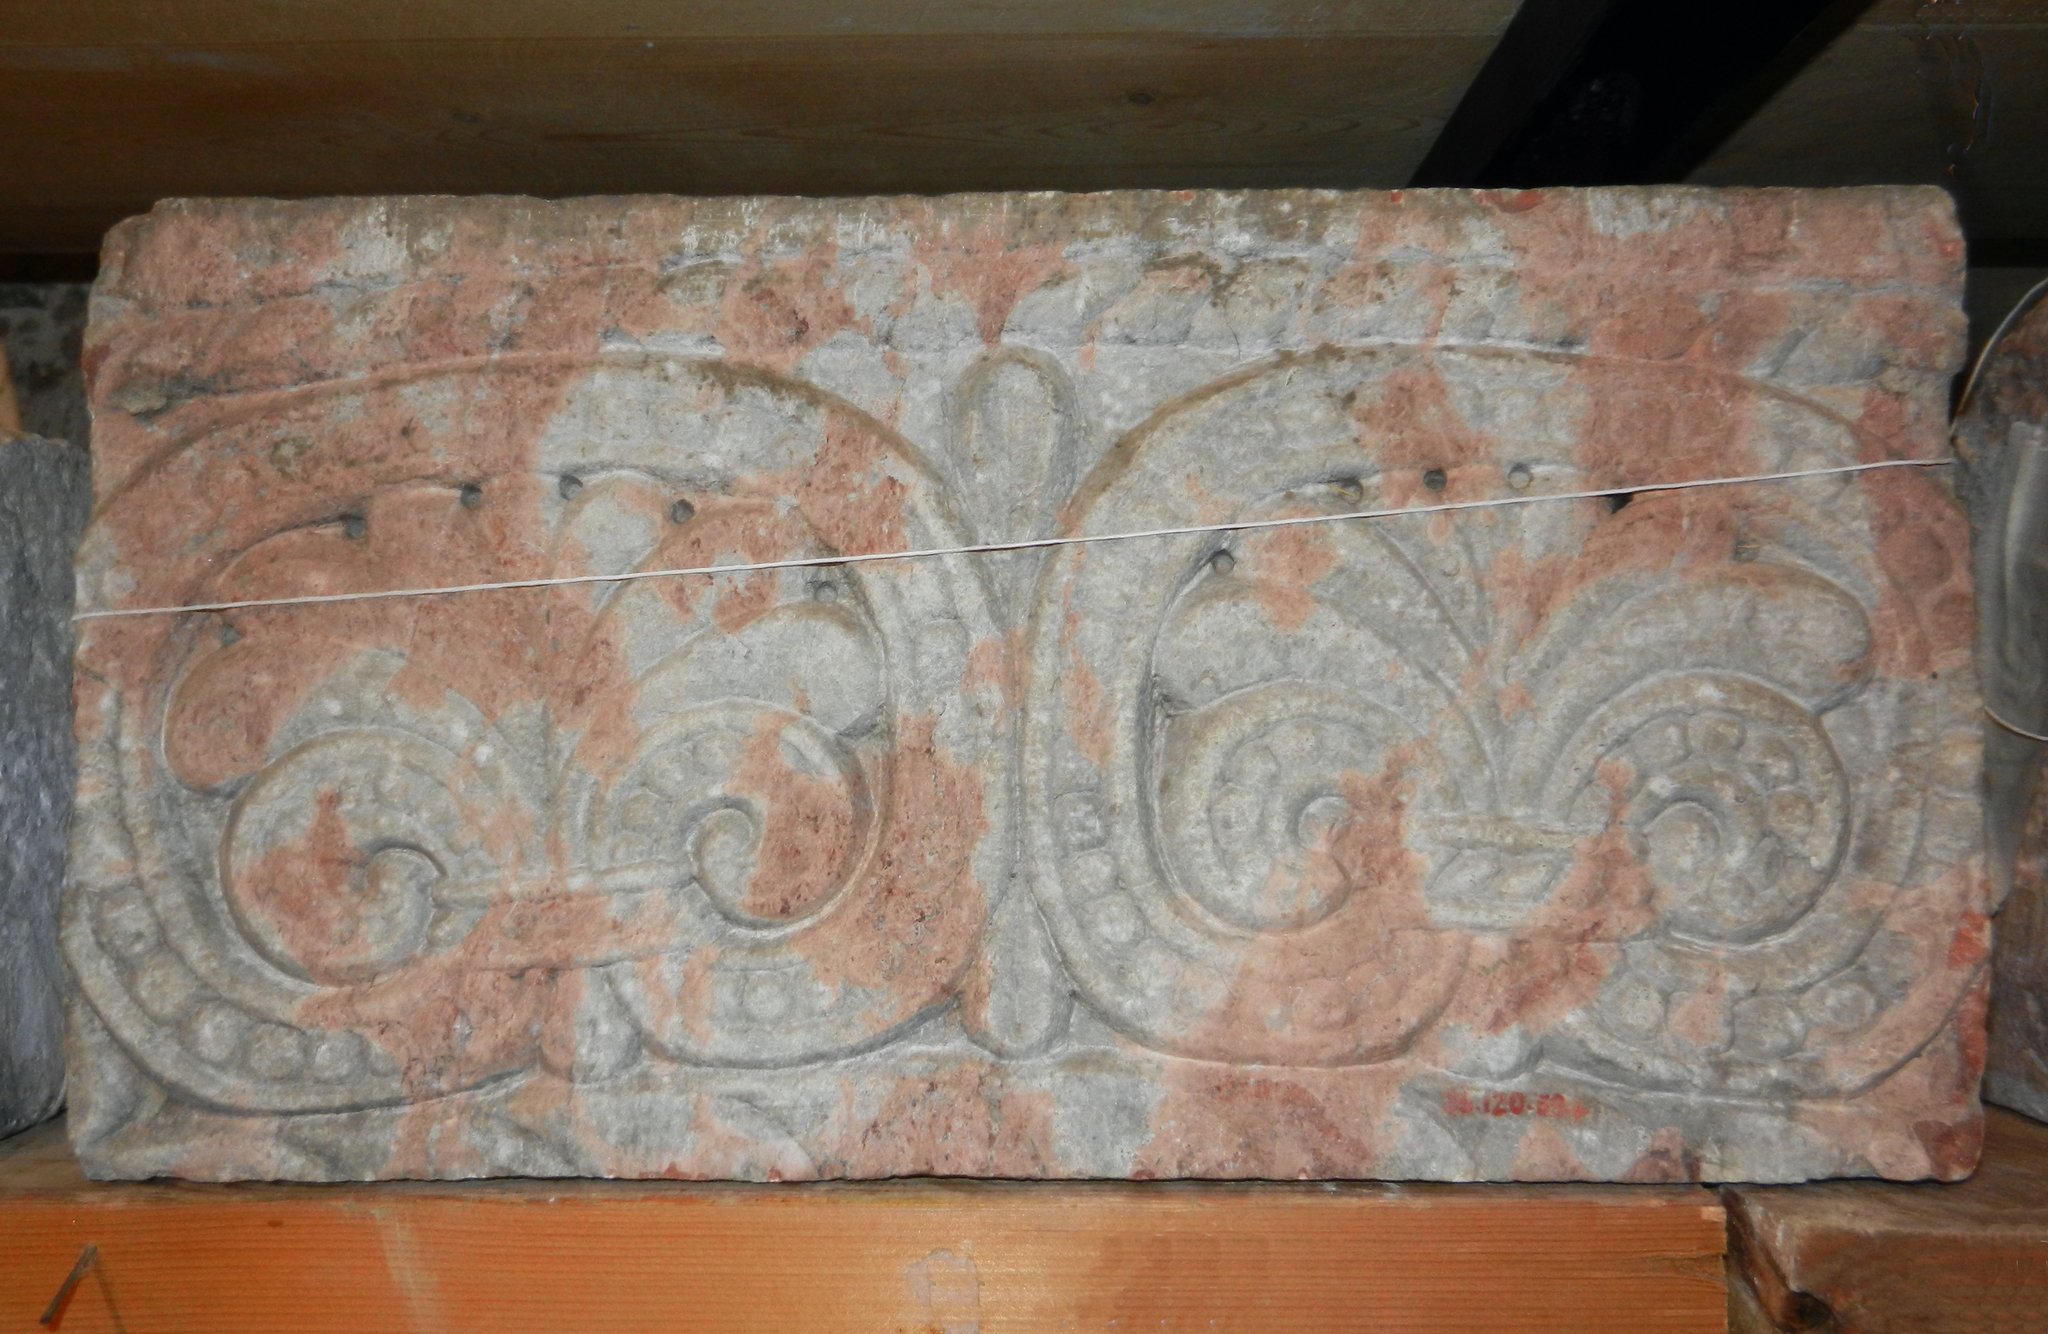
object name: lintel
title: Lintel Fragment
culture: catalan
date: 1130-1140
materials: marble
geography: france